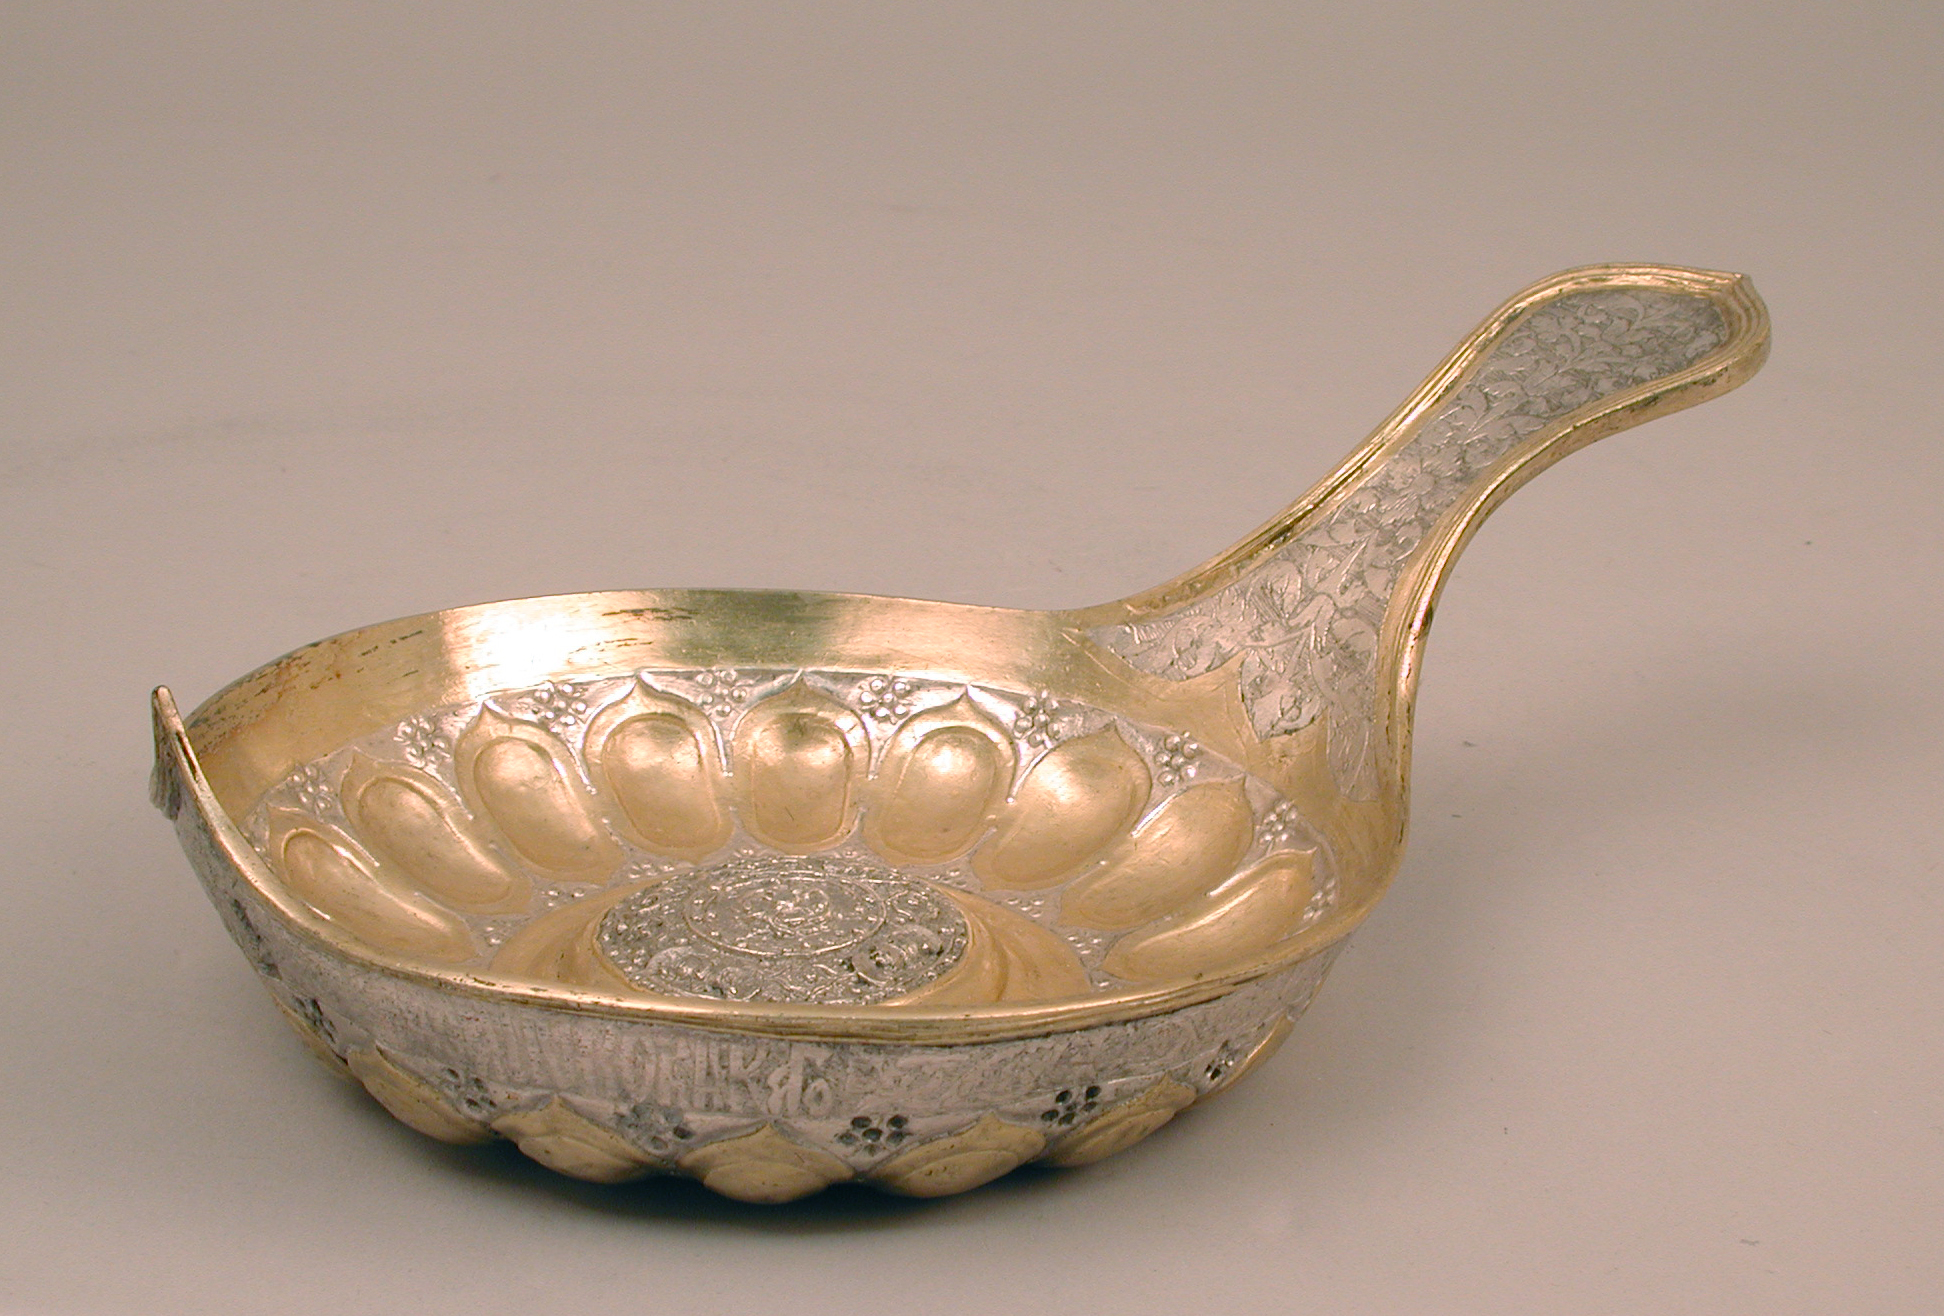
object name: ladle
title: Ladle (Puisoir)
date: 1801-1900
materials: gilt, silver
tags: flowers,ladles